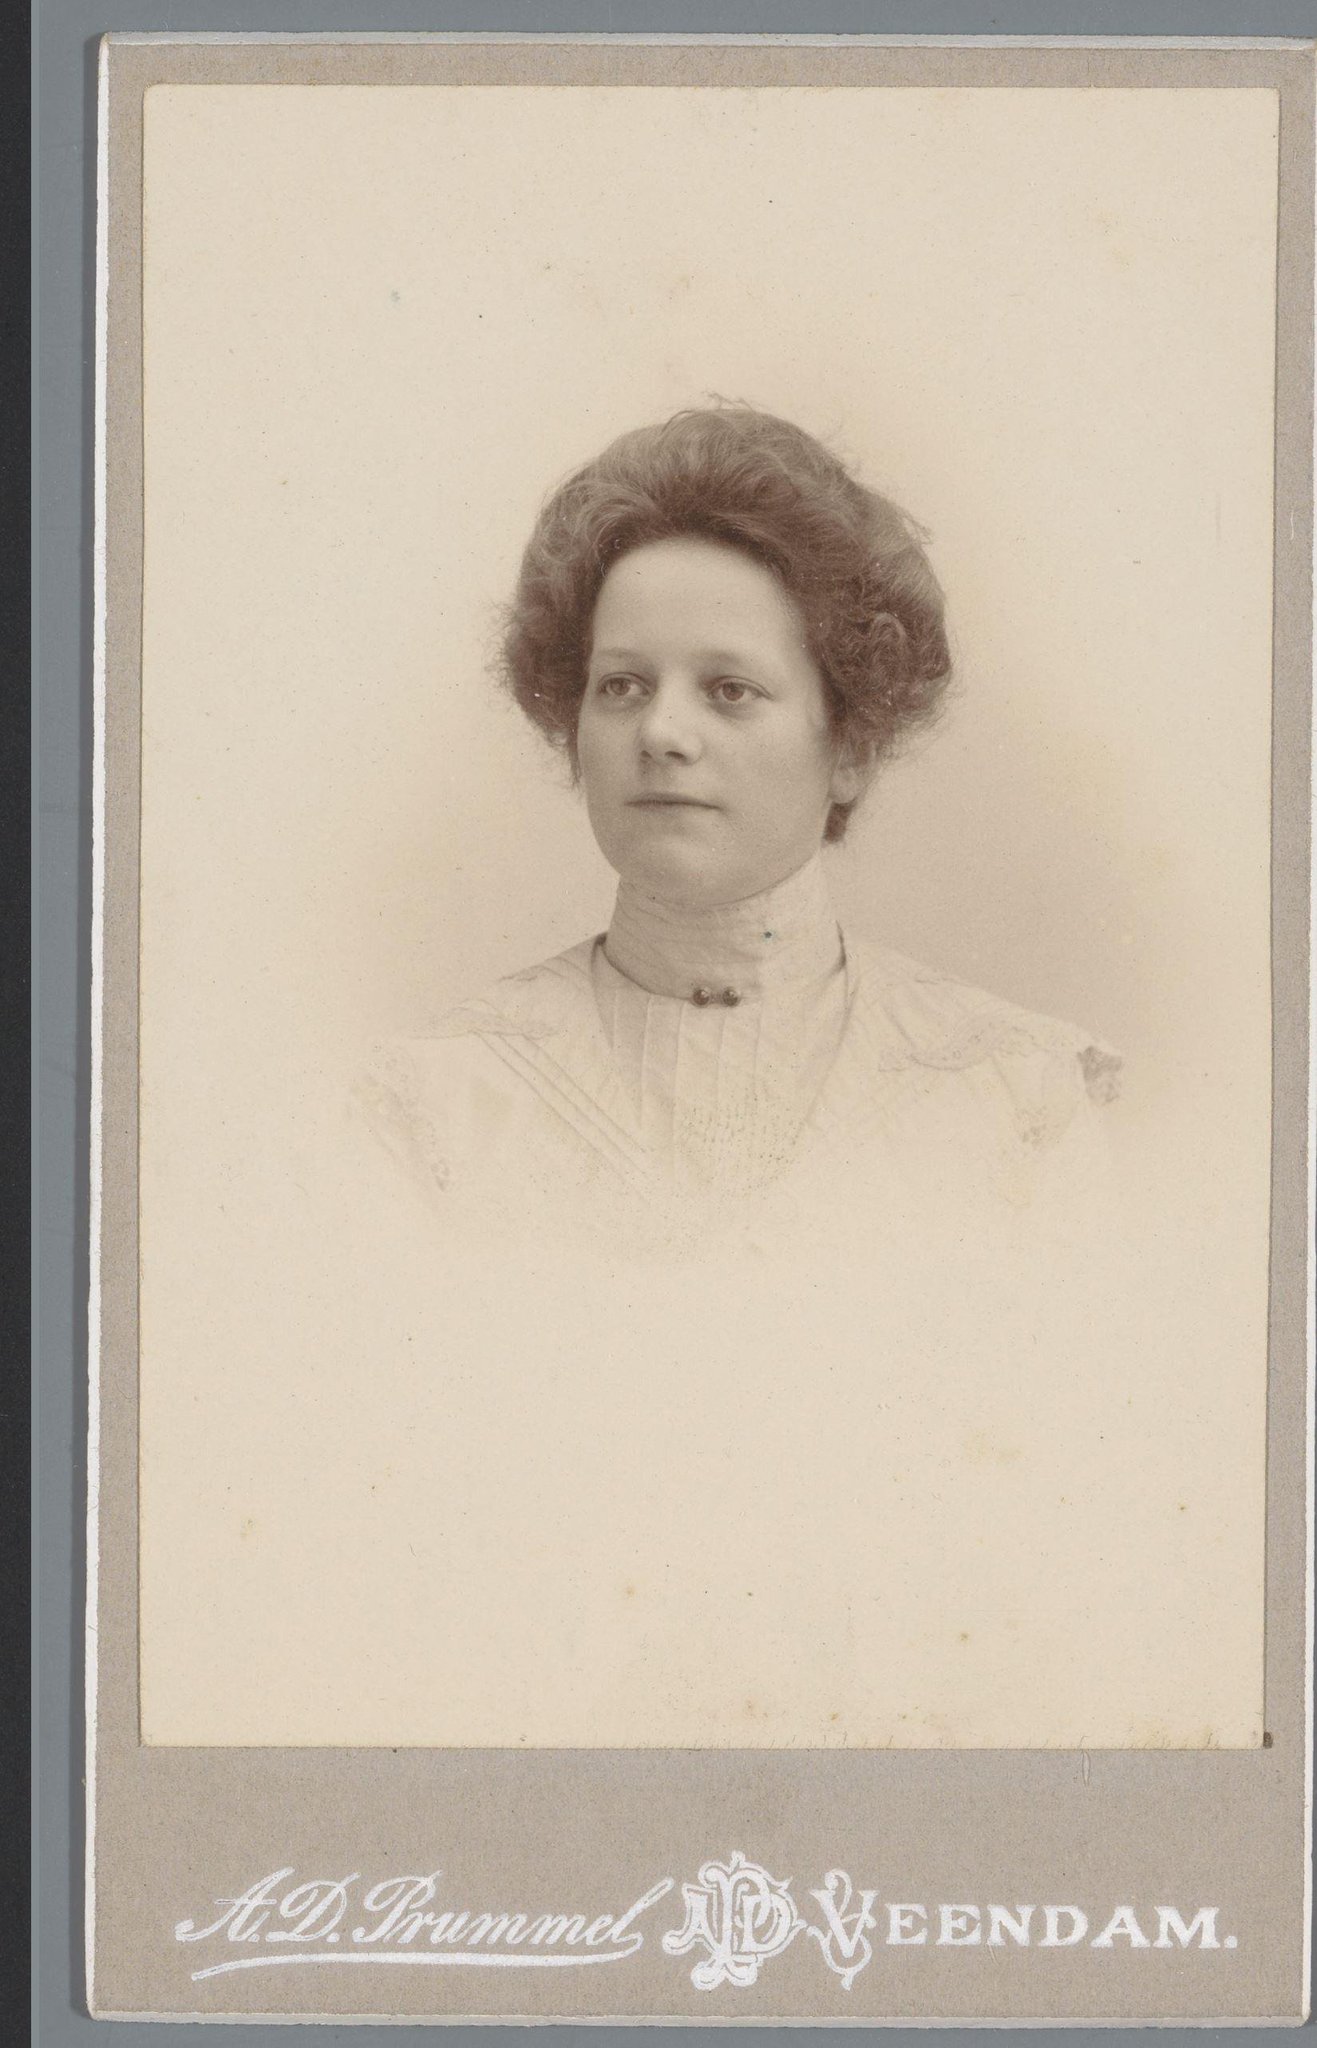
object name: photograph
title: Portret van een onbekende vrouw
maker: albert daniel prummel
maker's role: fotograaf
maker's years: 1862-1940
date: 1900-1921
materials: paper, cardboard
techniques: gelatin silver print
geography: veendam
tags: adult woman, anonymous historical person portrayed